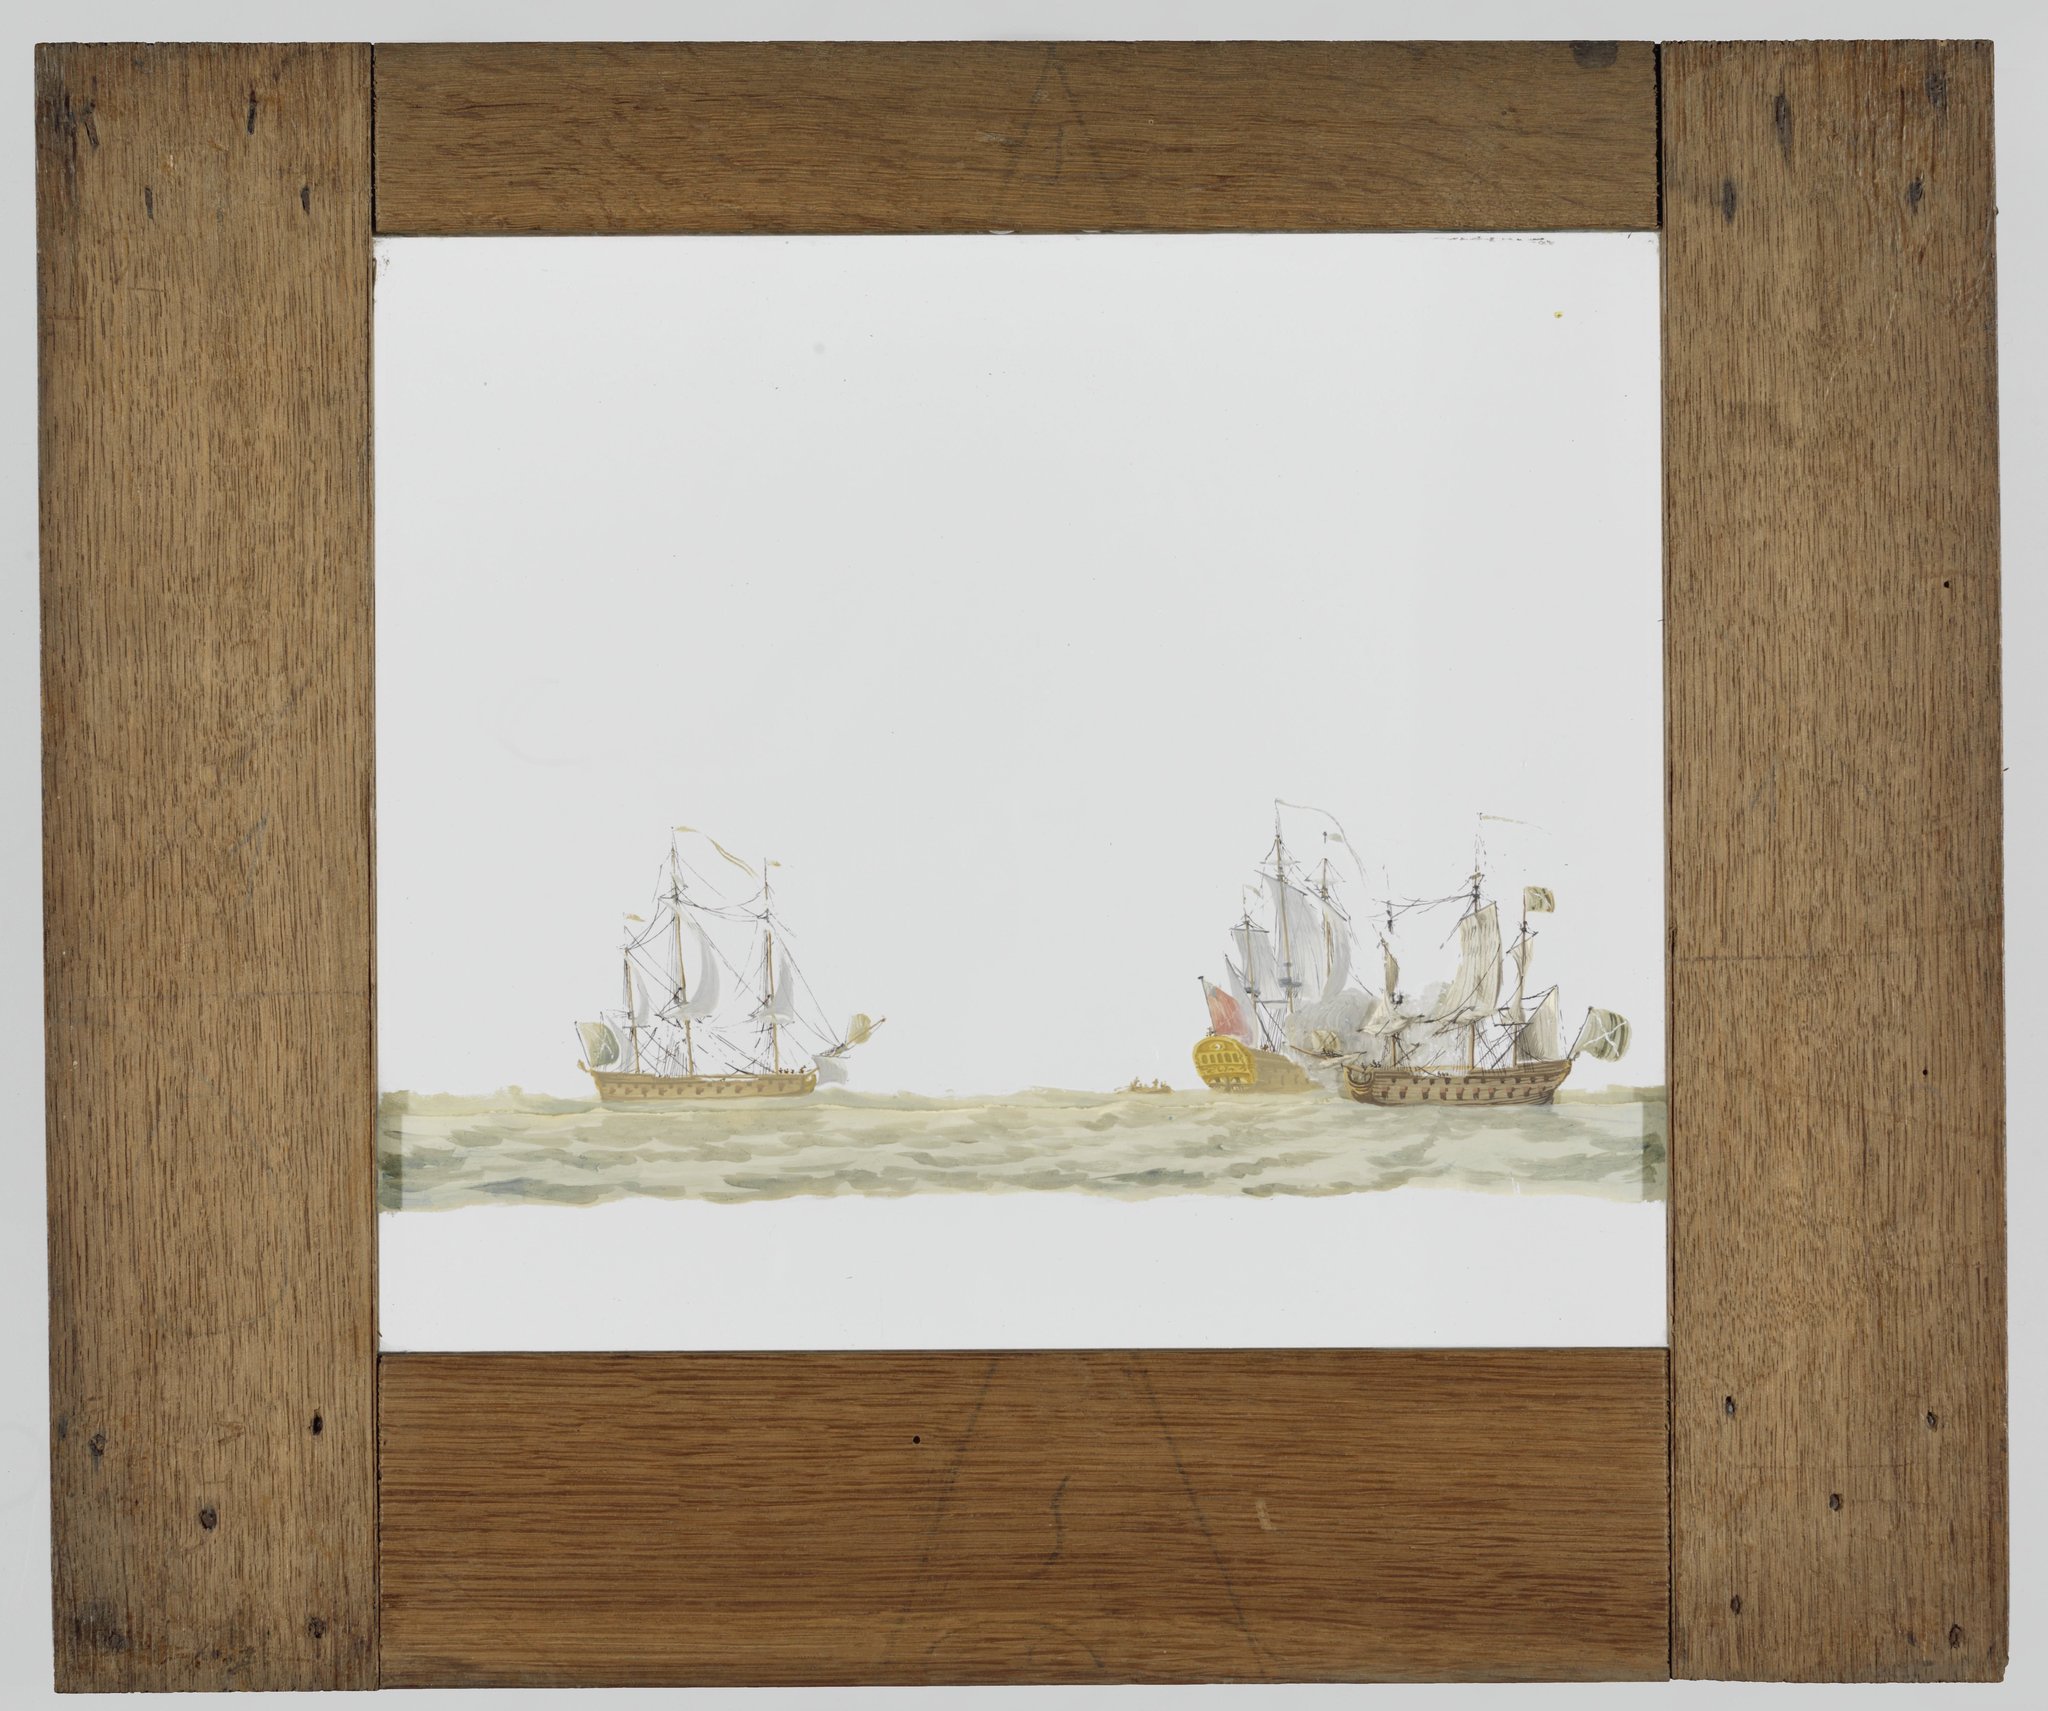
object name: diafanoramaplaat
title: Diaphanorama of a naval battle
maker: Anonymous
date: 1750-1830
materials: glass, wood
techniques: painted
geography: netherlands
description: Diaphanoramas are particularly suited to scenes with a lot of spatial depth, such as landscapes and naval battles. Interiors were also popular subjects. This naval battle consists of three glass plates painted on both sides, which the maker has effectively used to evoke a strong sense of recession.